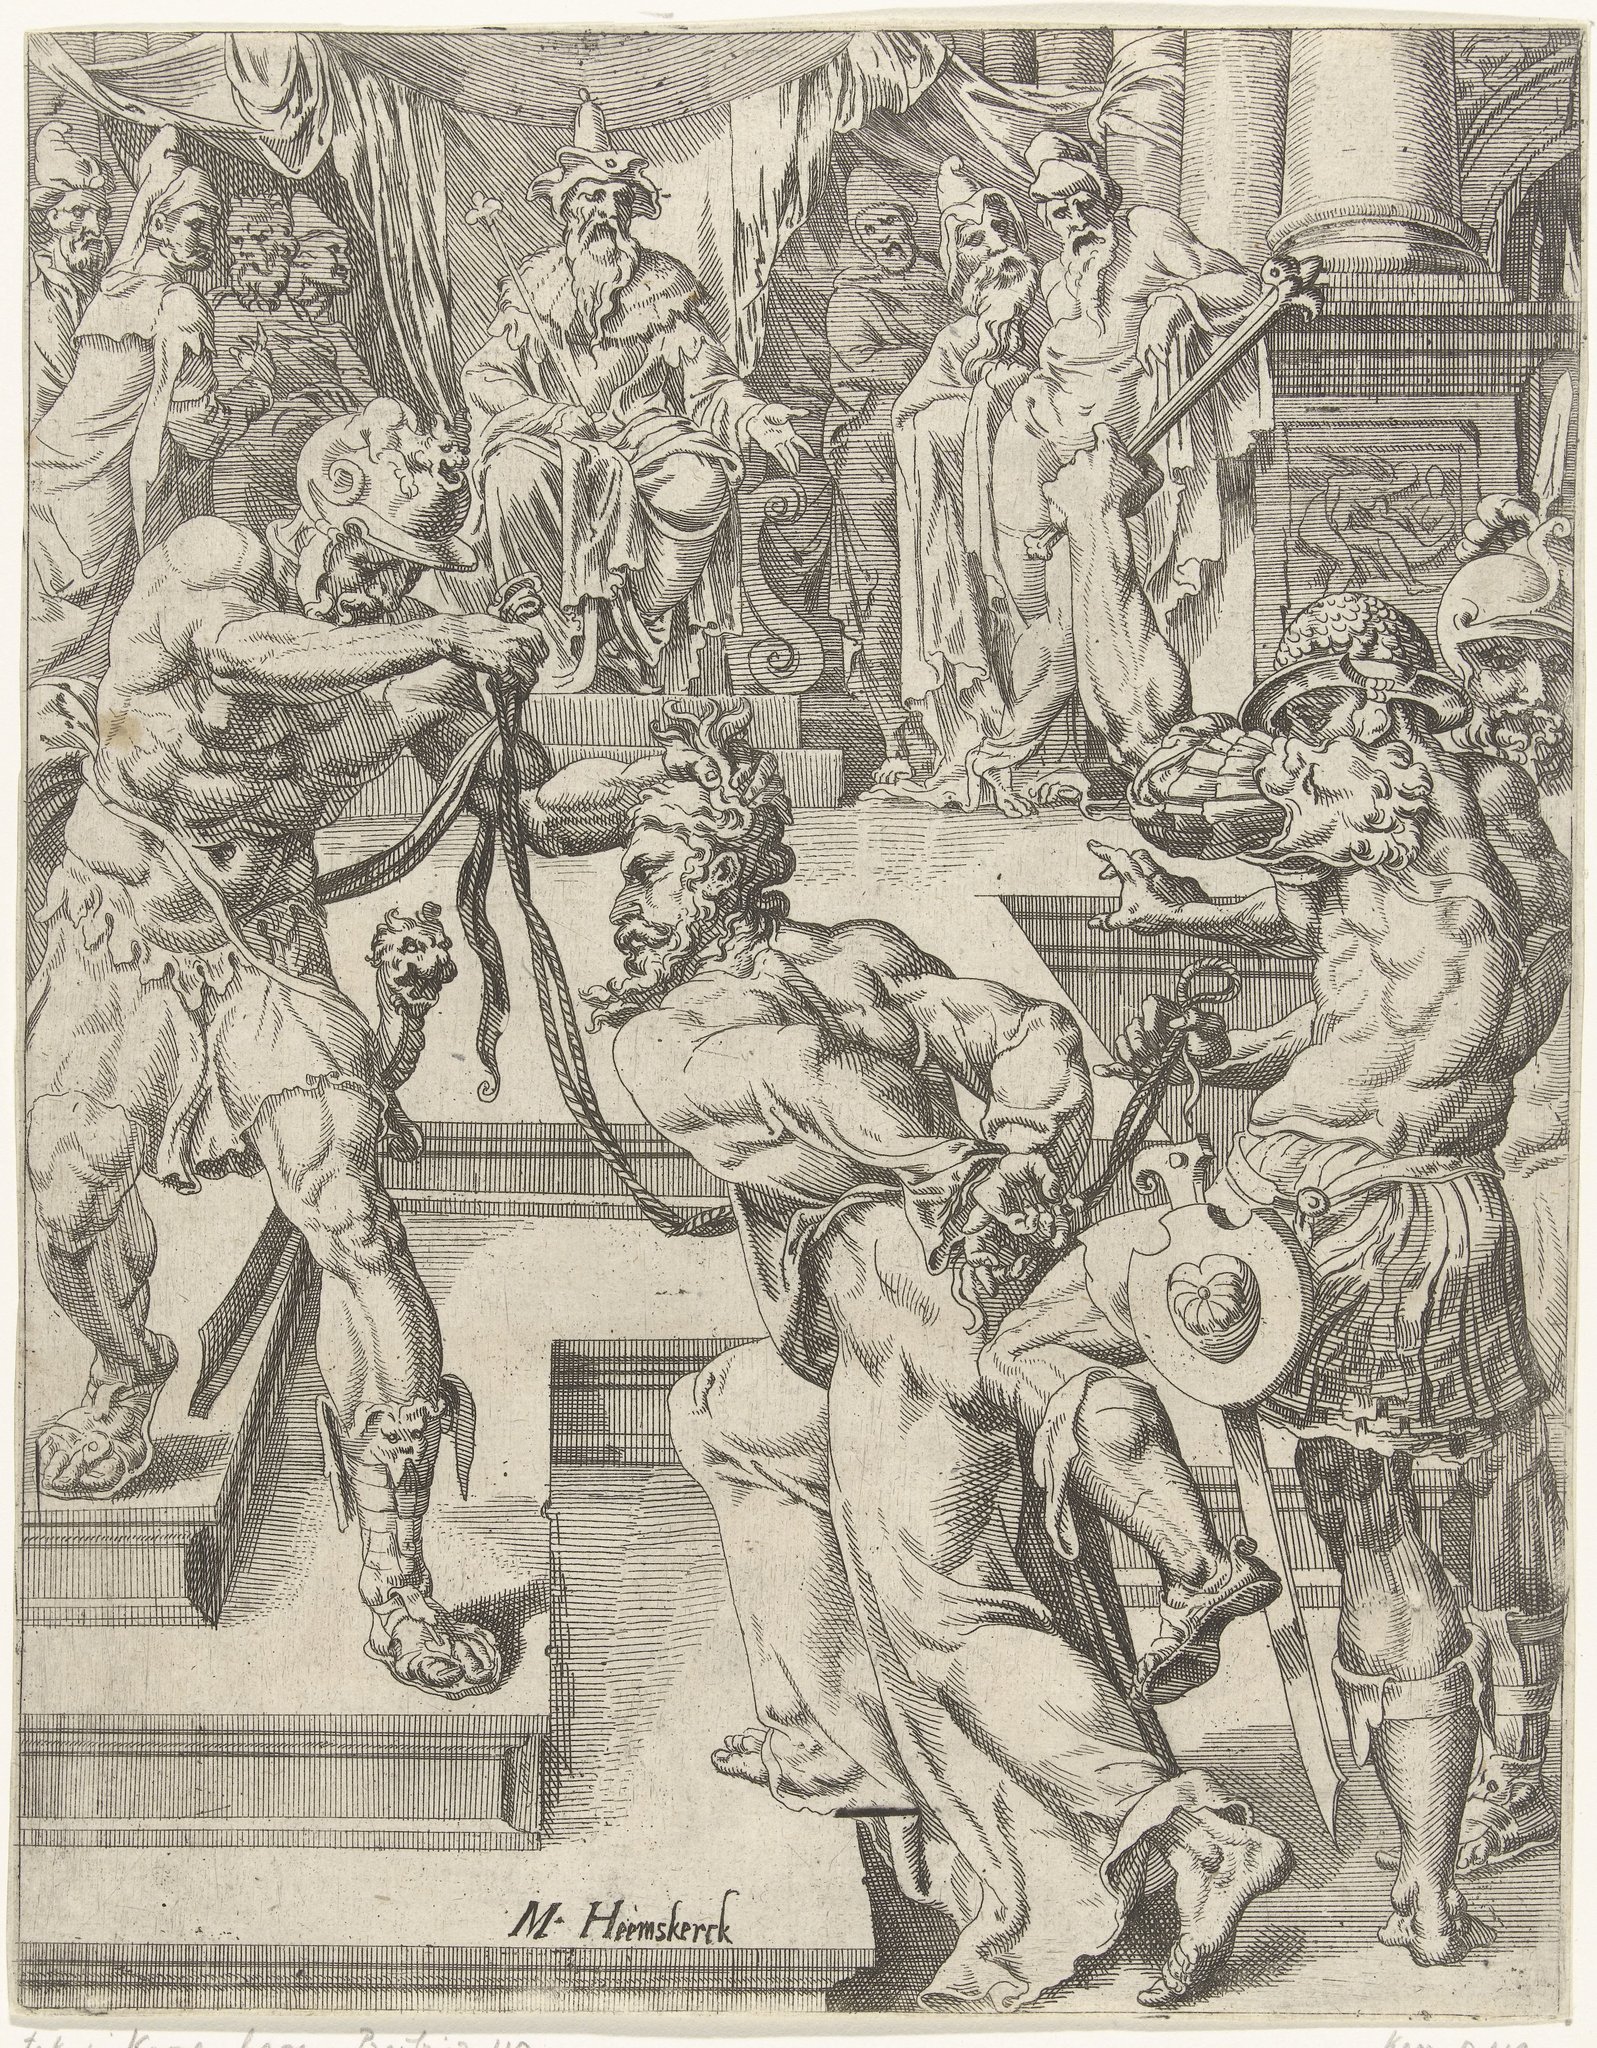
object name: print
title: Val en de verlossing van de mensheid door het leven en passie van Christus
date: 1548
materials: paper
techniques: etching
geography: haarlem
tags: christ before the sanhedrin with caiaphas as high priest, and possibly annas; maybe a soldier about to strike christ because he keeps silent (matthew 26:57-66; mark 14:53-64; luke 22:54, 22:66-71)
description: Christus wordt hardhandig voorgeleid bij hogepriester Kajafas. Soldaten slaan hem en trekken aan zijn haren. De prent is deel van een dertigdelige serie met prenten over de zondeval en Christus' passie.